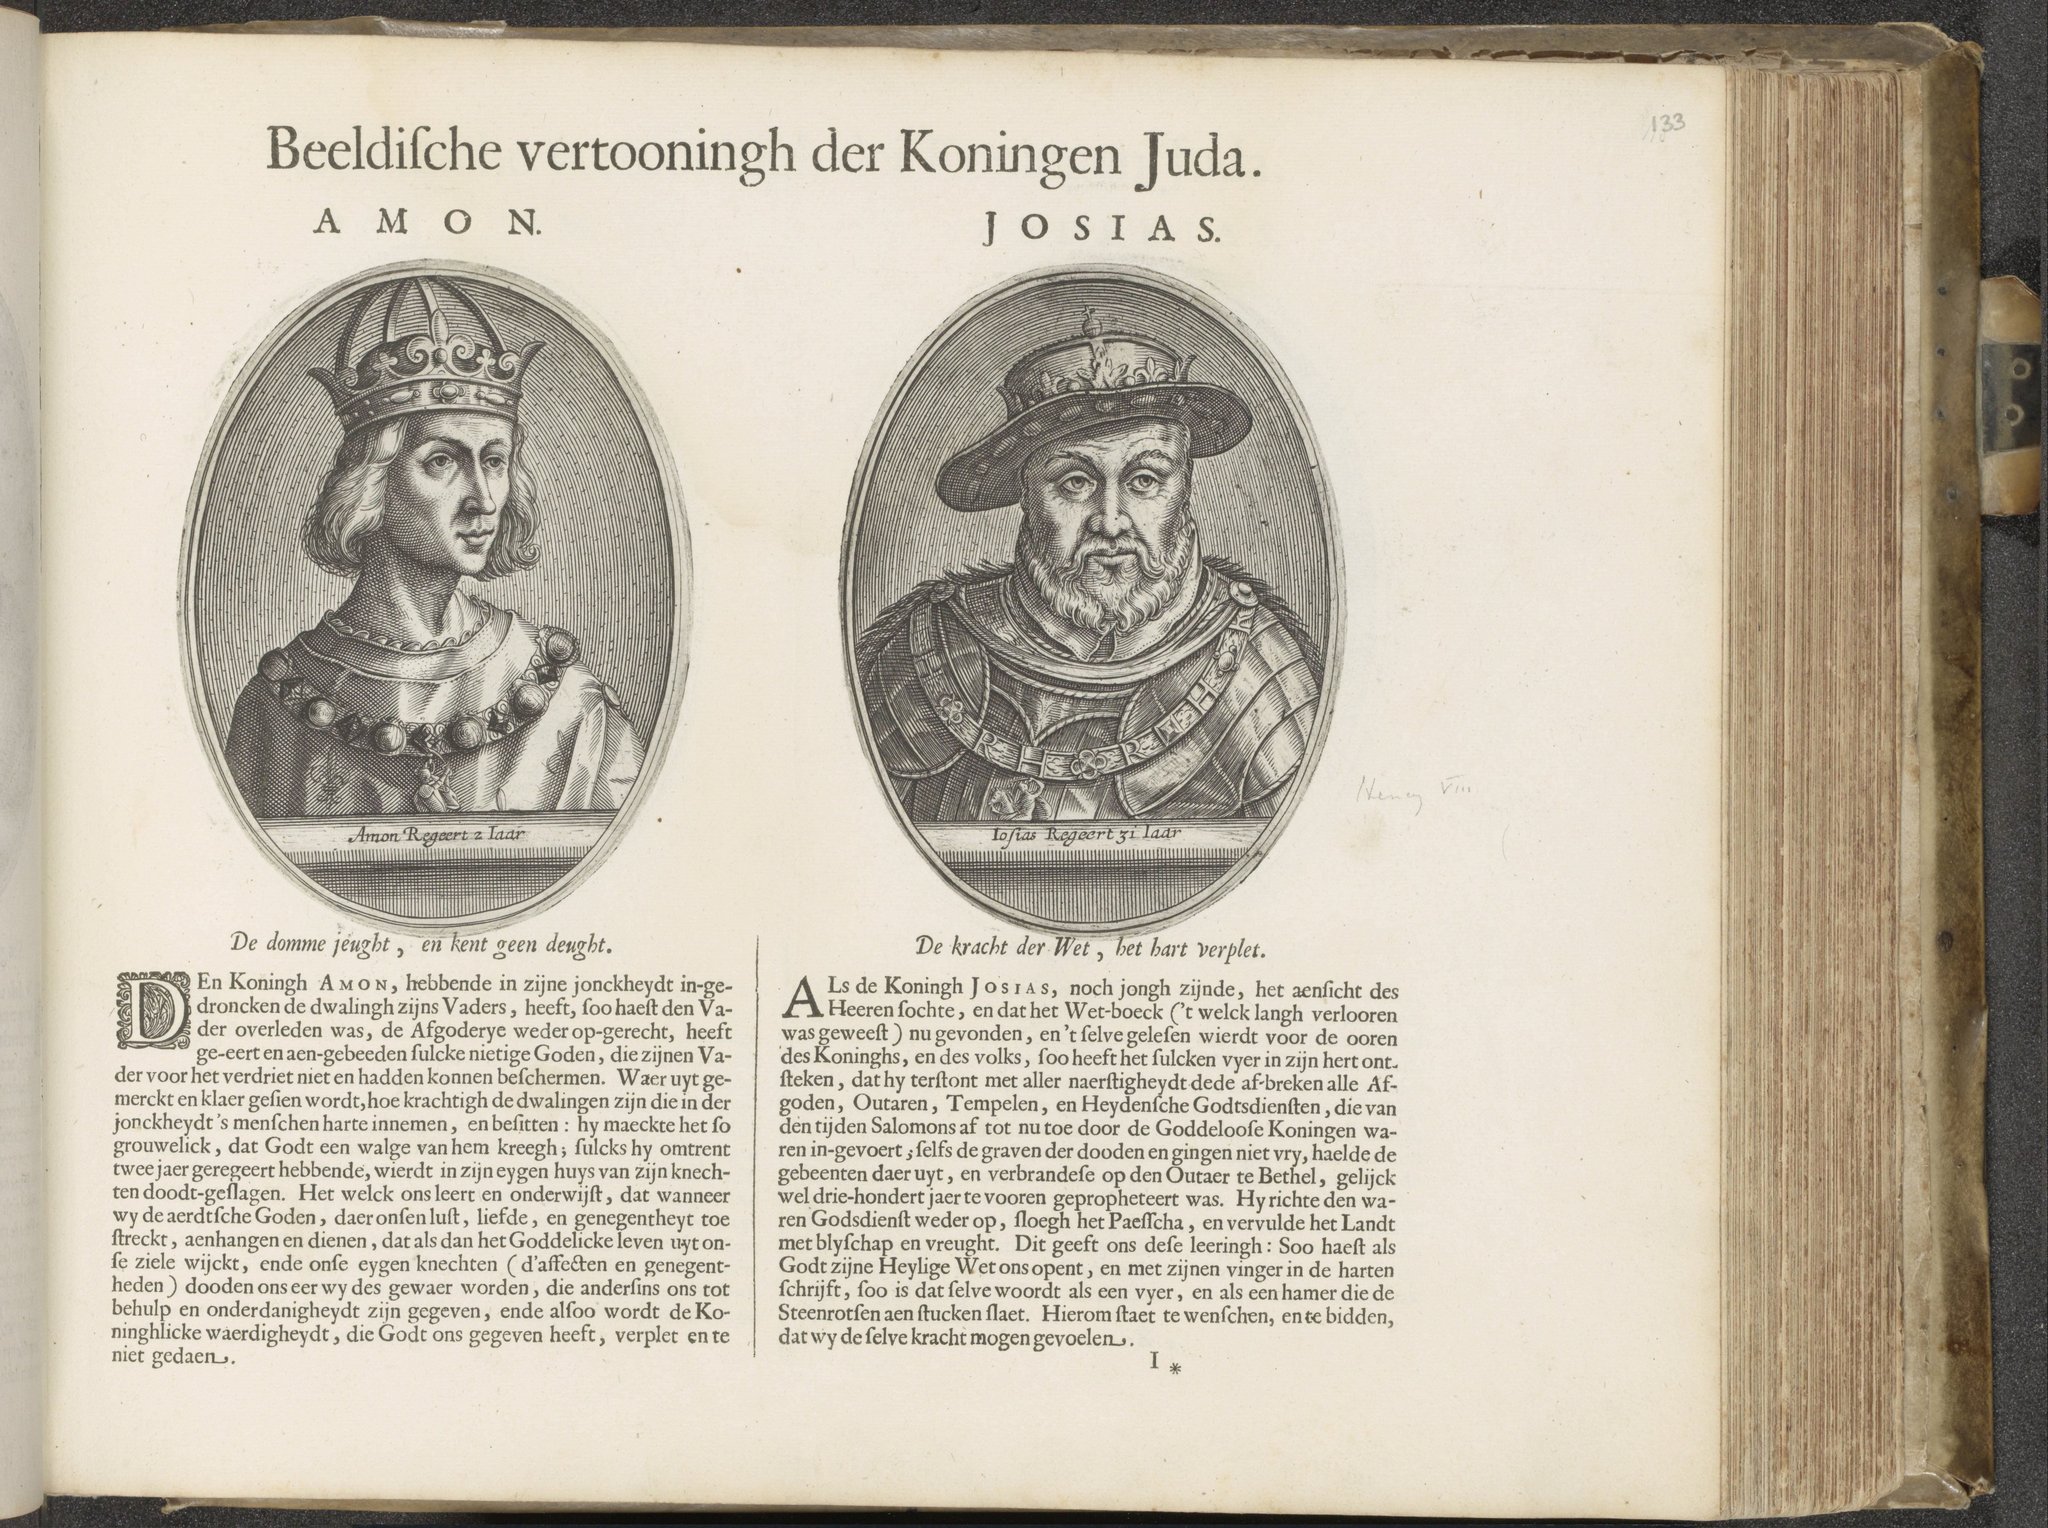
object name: text sheet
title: Den Grooten Emblemata Sacra, bestaande in meer dan vier hondert bybelsche figuren, zoo des Ouden als des Nieuwen Testaments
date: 1610-1625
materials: paper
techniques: engraving, letterpress printing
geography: amsterdam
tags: paris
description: Portretten van Lodewijk XII van Frankrijk en Hendrik VII van Engeland, in dit album gebruikt als afbeeldingen van respectievelijk Amon en Josia. De begeleidende tekst begint met een kleine gedecoreerde initiaal D. Het blad maakt deel uit van een album.